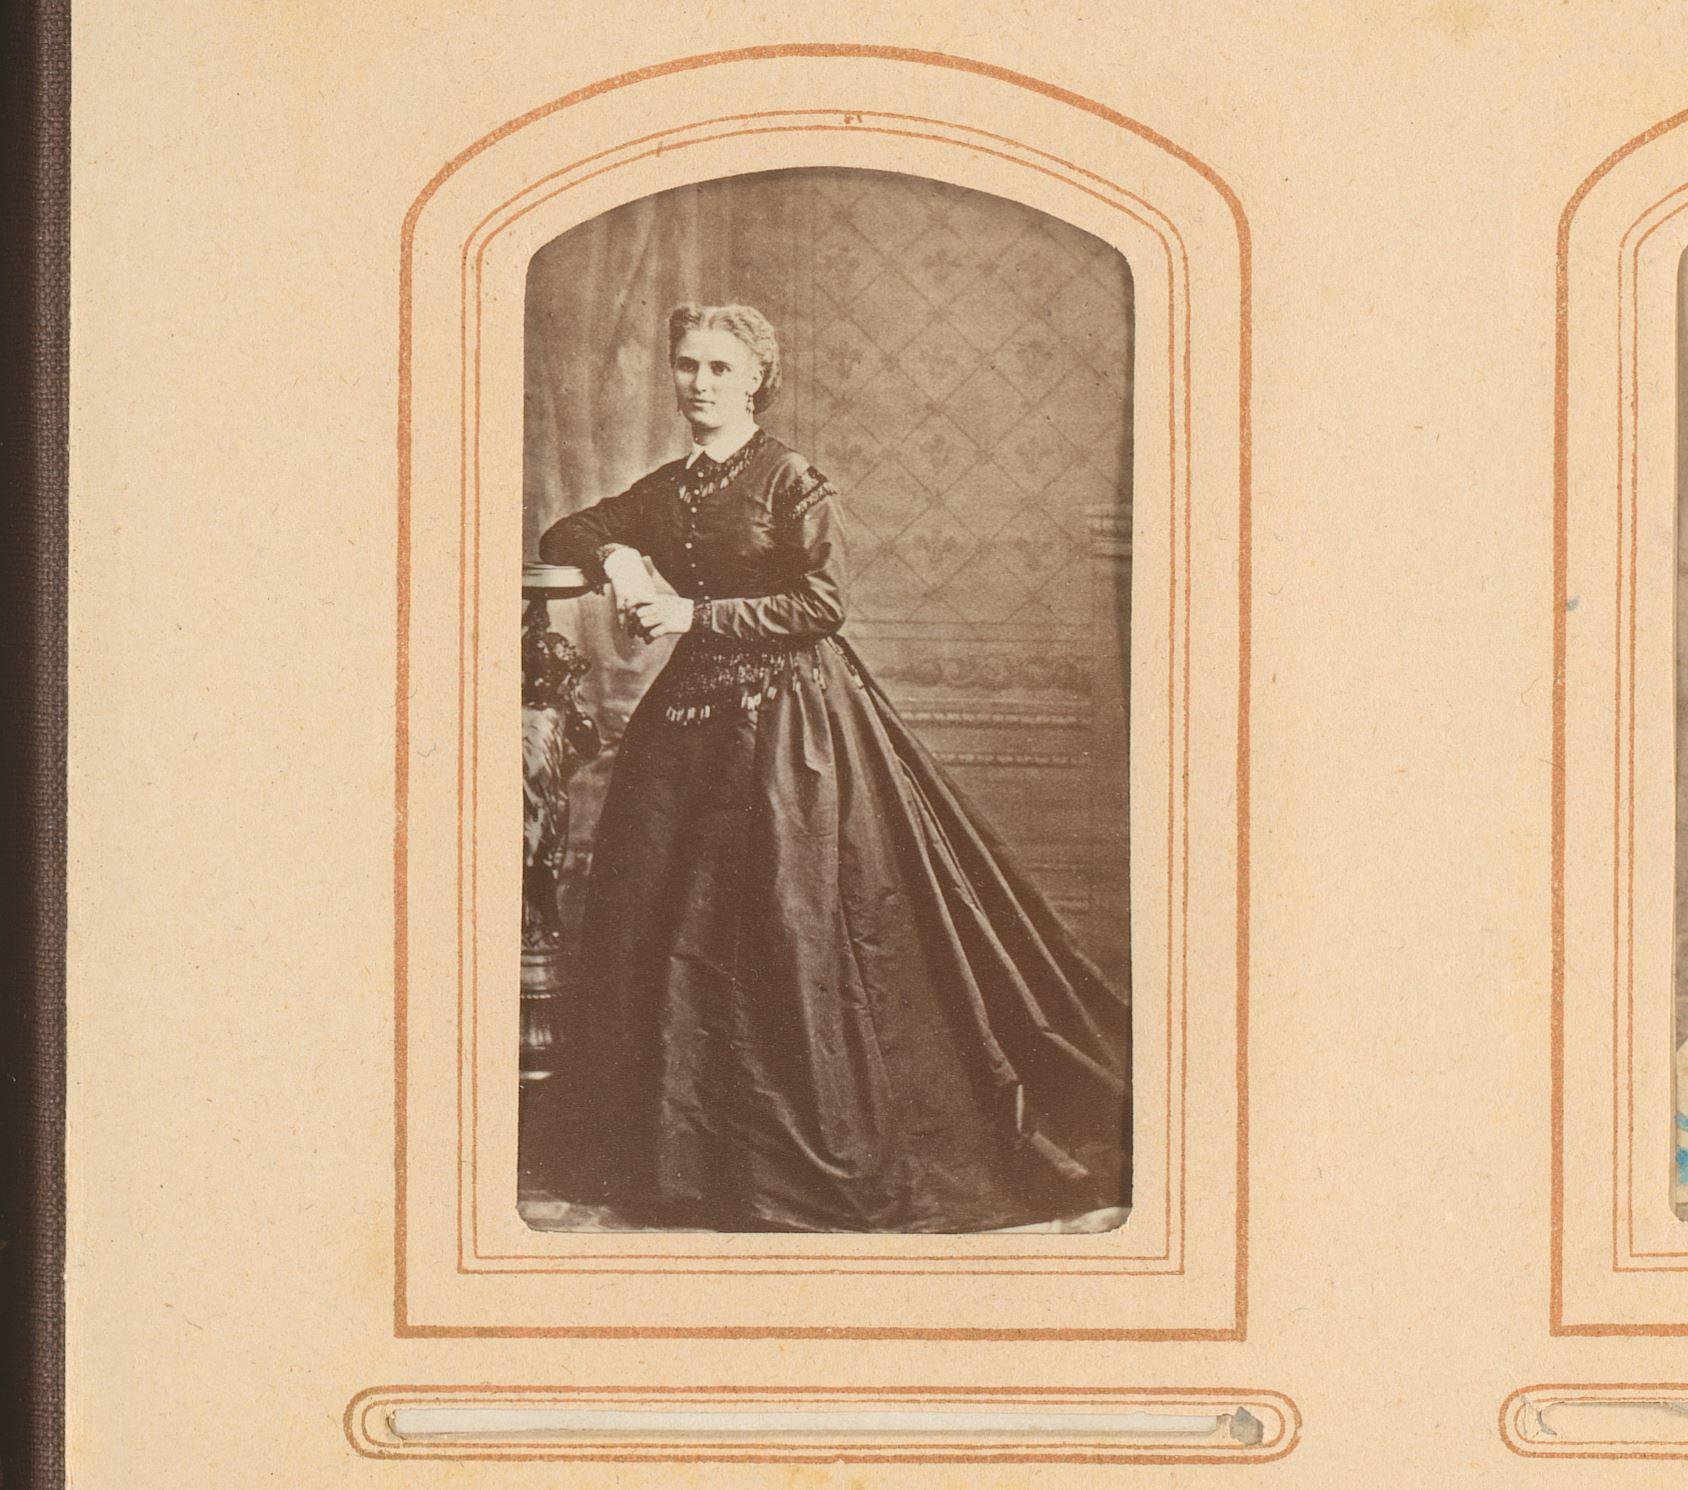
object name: photograph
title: Portret van Christina Nilsson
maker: Anonymous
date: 1860-1890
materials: cardboard, photographic support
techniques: albumen print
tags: historical persons, portrait of opera-singer, standing figure - aa - female human figure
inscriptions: annotation: ‘Christina Nilsson’